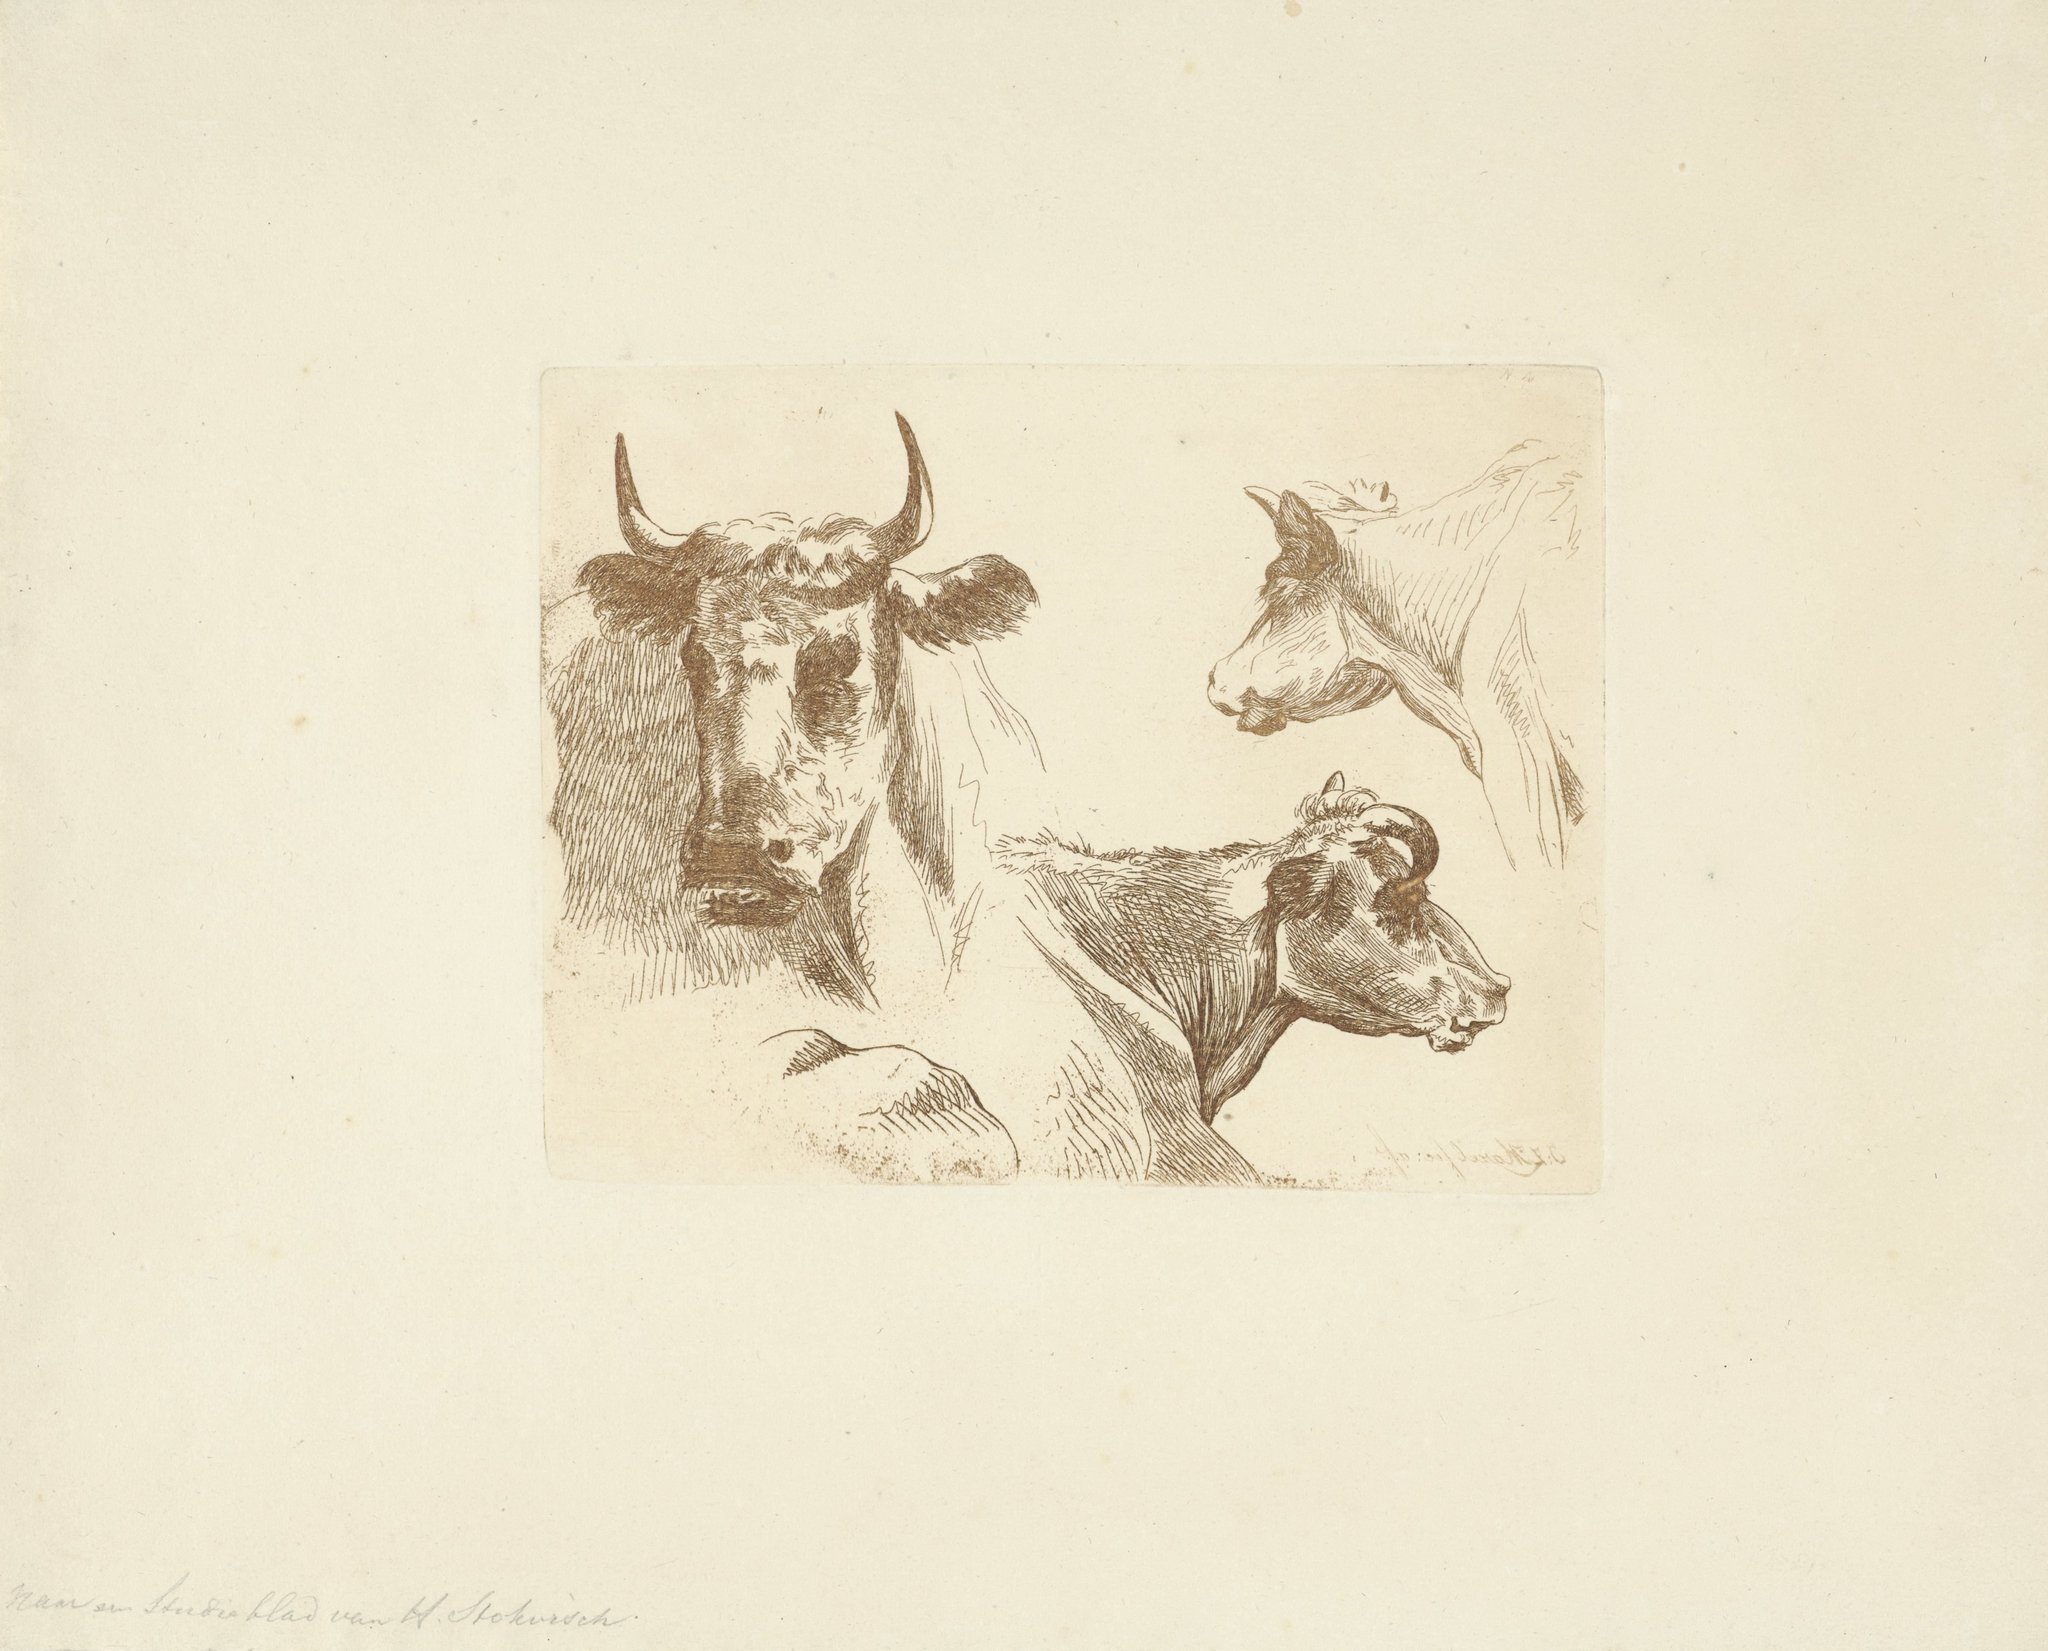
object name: print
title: Drie koeienkoppen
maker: jean zacherie mazel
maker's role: draughtsman, print maker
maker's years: 1792-1884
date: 1802-1884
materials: paper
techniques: etching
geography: netherlands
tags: cow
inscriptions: collector's mark: Lugt 2233